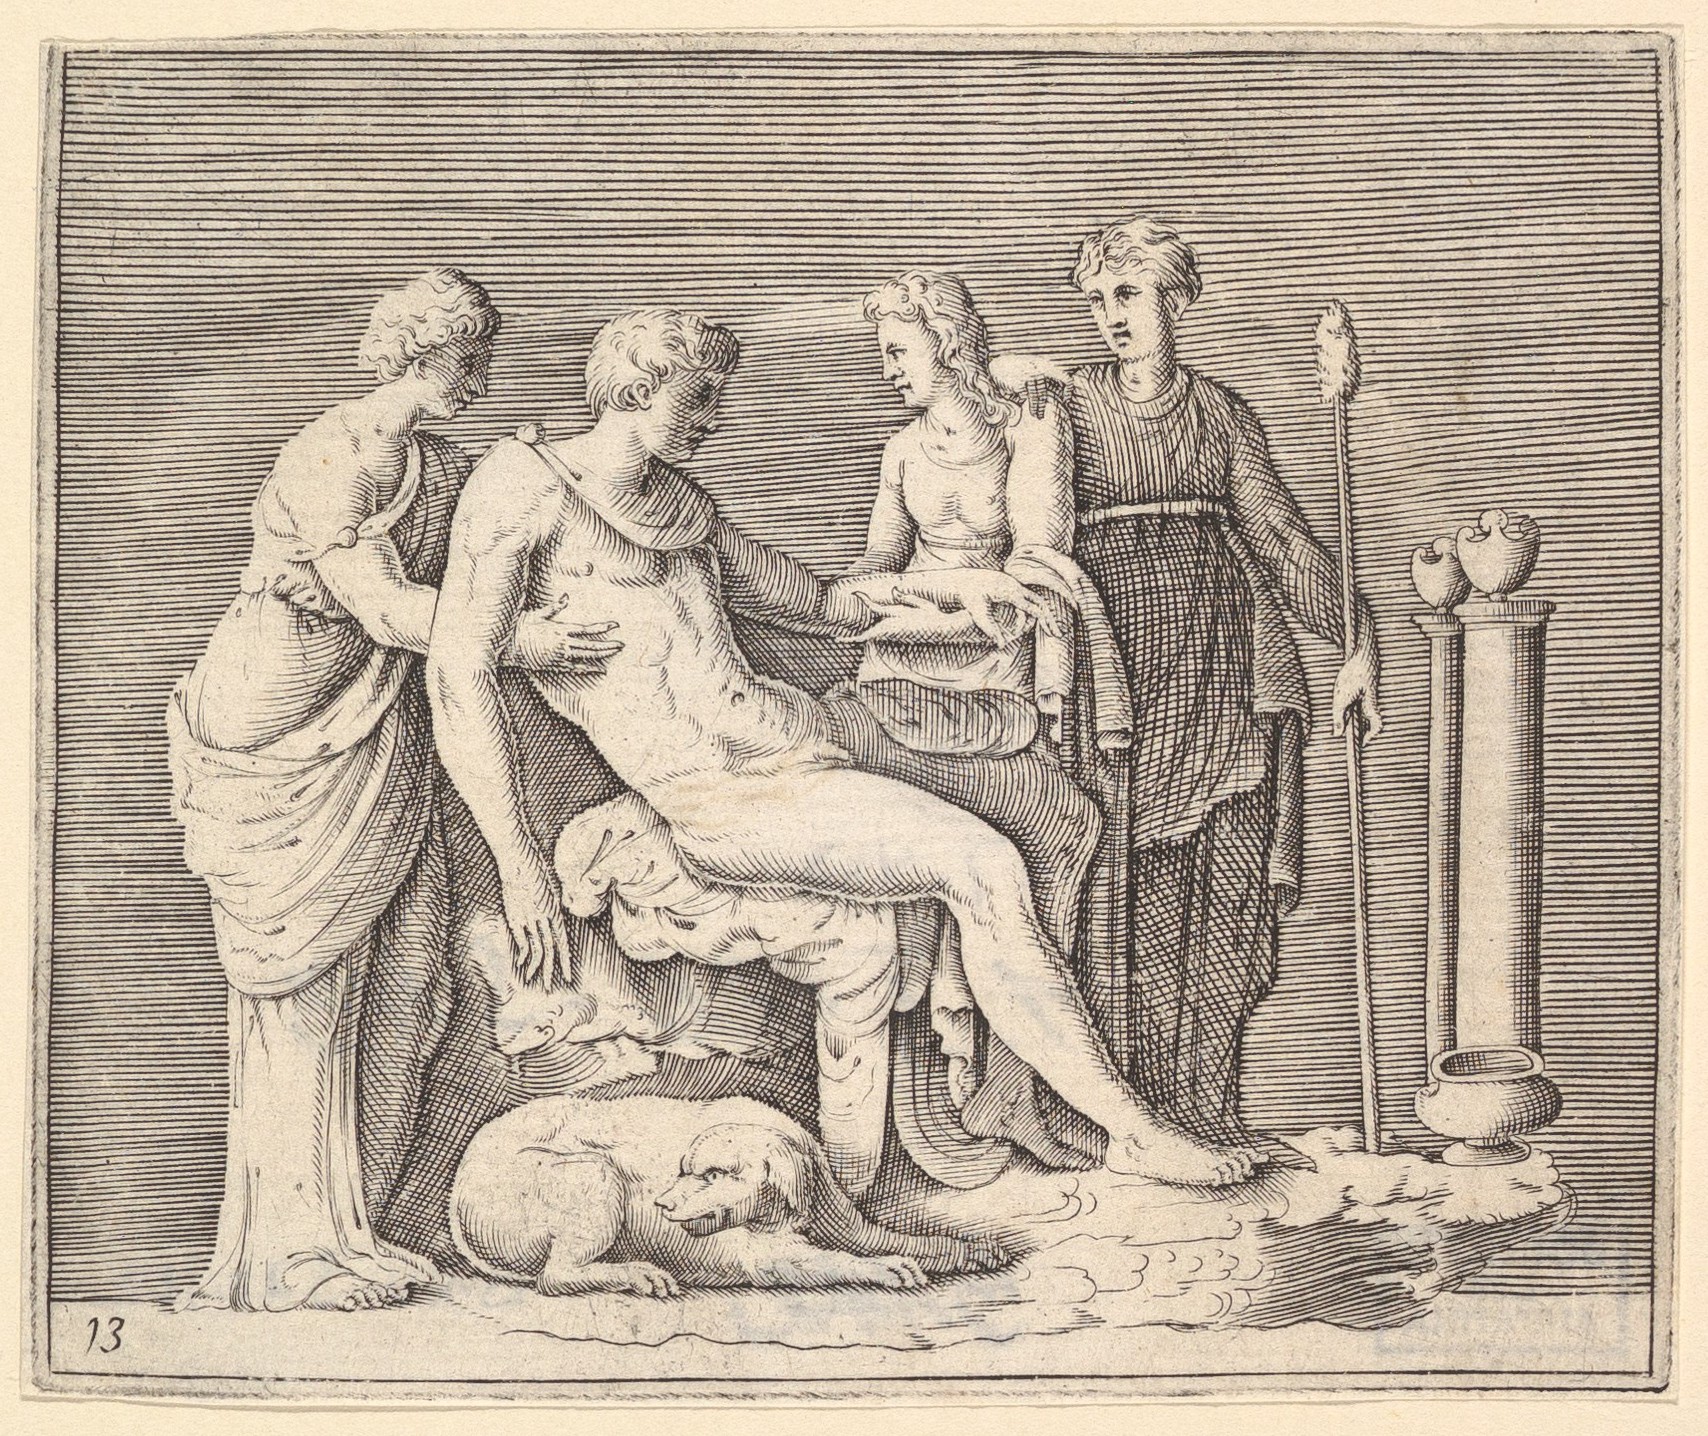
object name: print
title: Man Attended by Three Women, from "Ex Antiquis Cameorum et Gemmae Delineata/ Liber Secundus/et ab Enea Vico Parmen Incis"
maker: anonymous, italian, 16th century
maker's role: artist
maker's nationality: italian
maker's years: 1500-1600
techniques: engraving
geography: rome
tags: male nudes,women,dogs